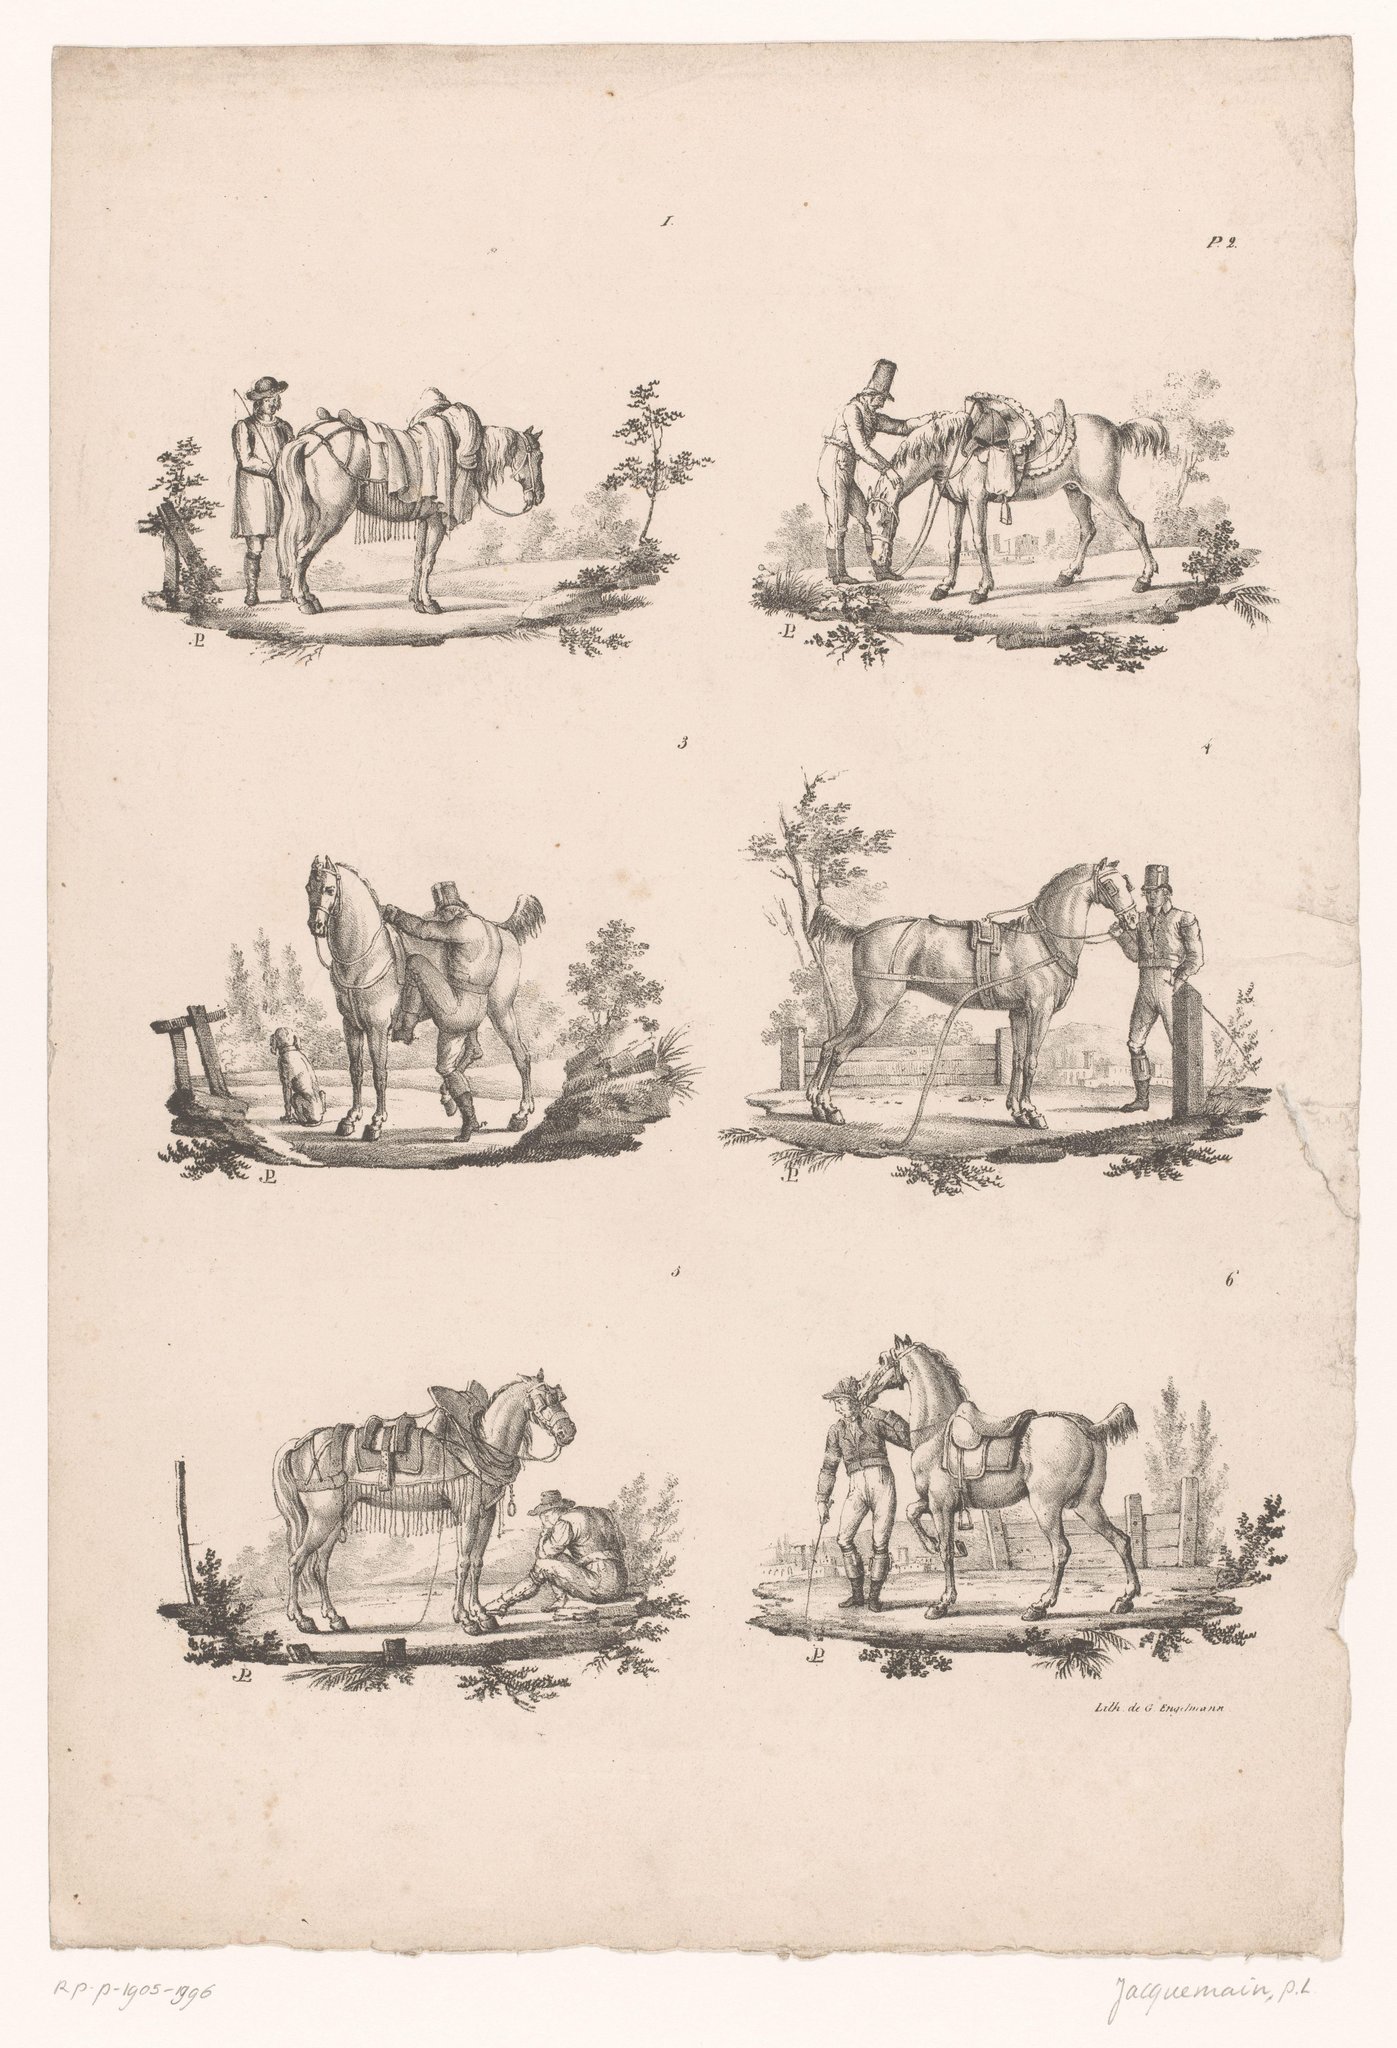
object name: print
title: Zes voorstellingen van een paard met ruiter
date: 1817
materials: paper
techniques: lithograph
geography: paris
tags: riding a horse, ass, or mule; rider, horseman, horse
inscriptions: collector's mark: Lugt 2228a